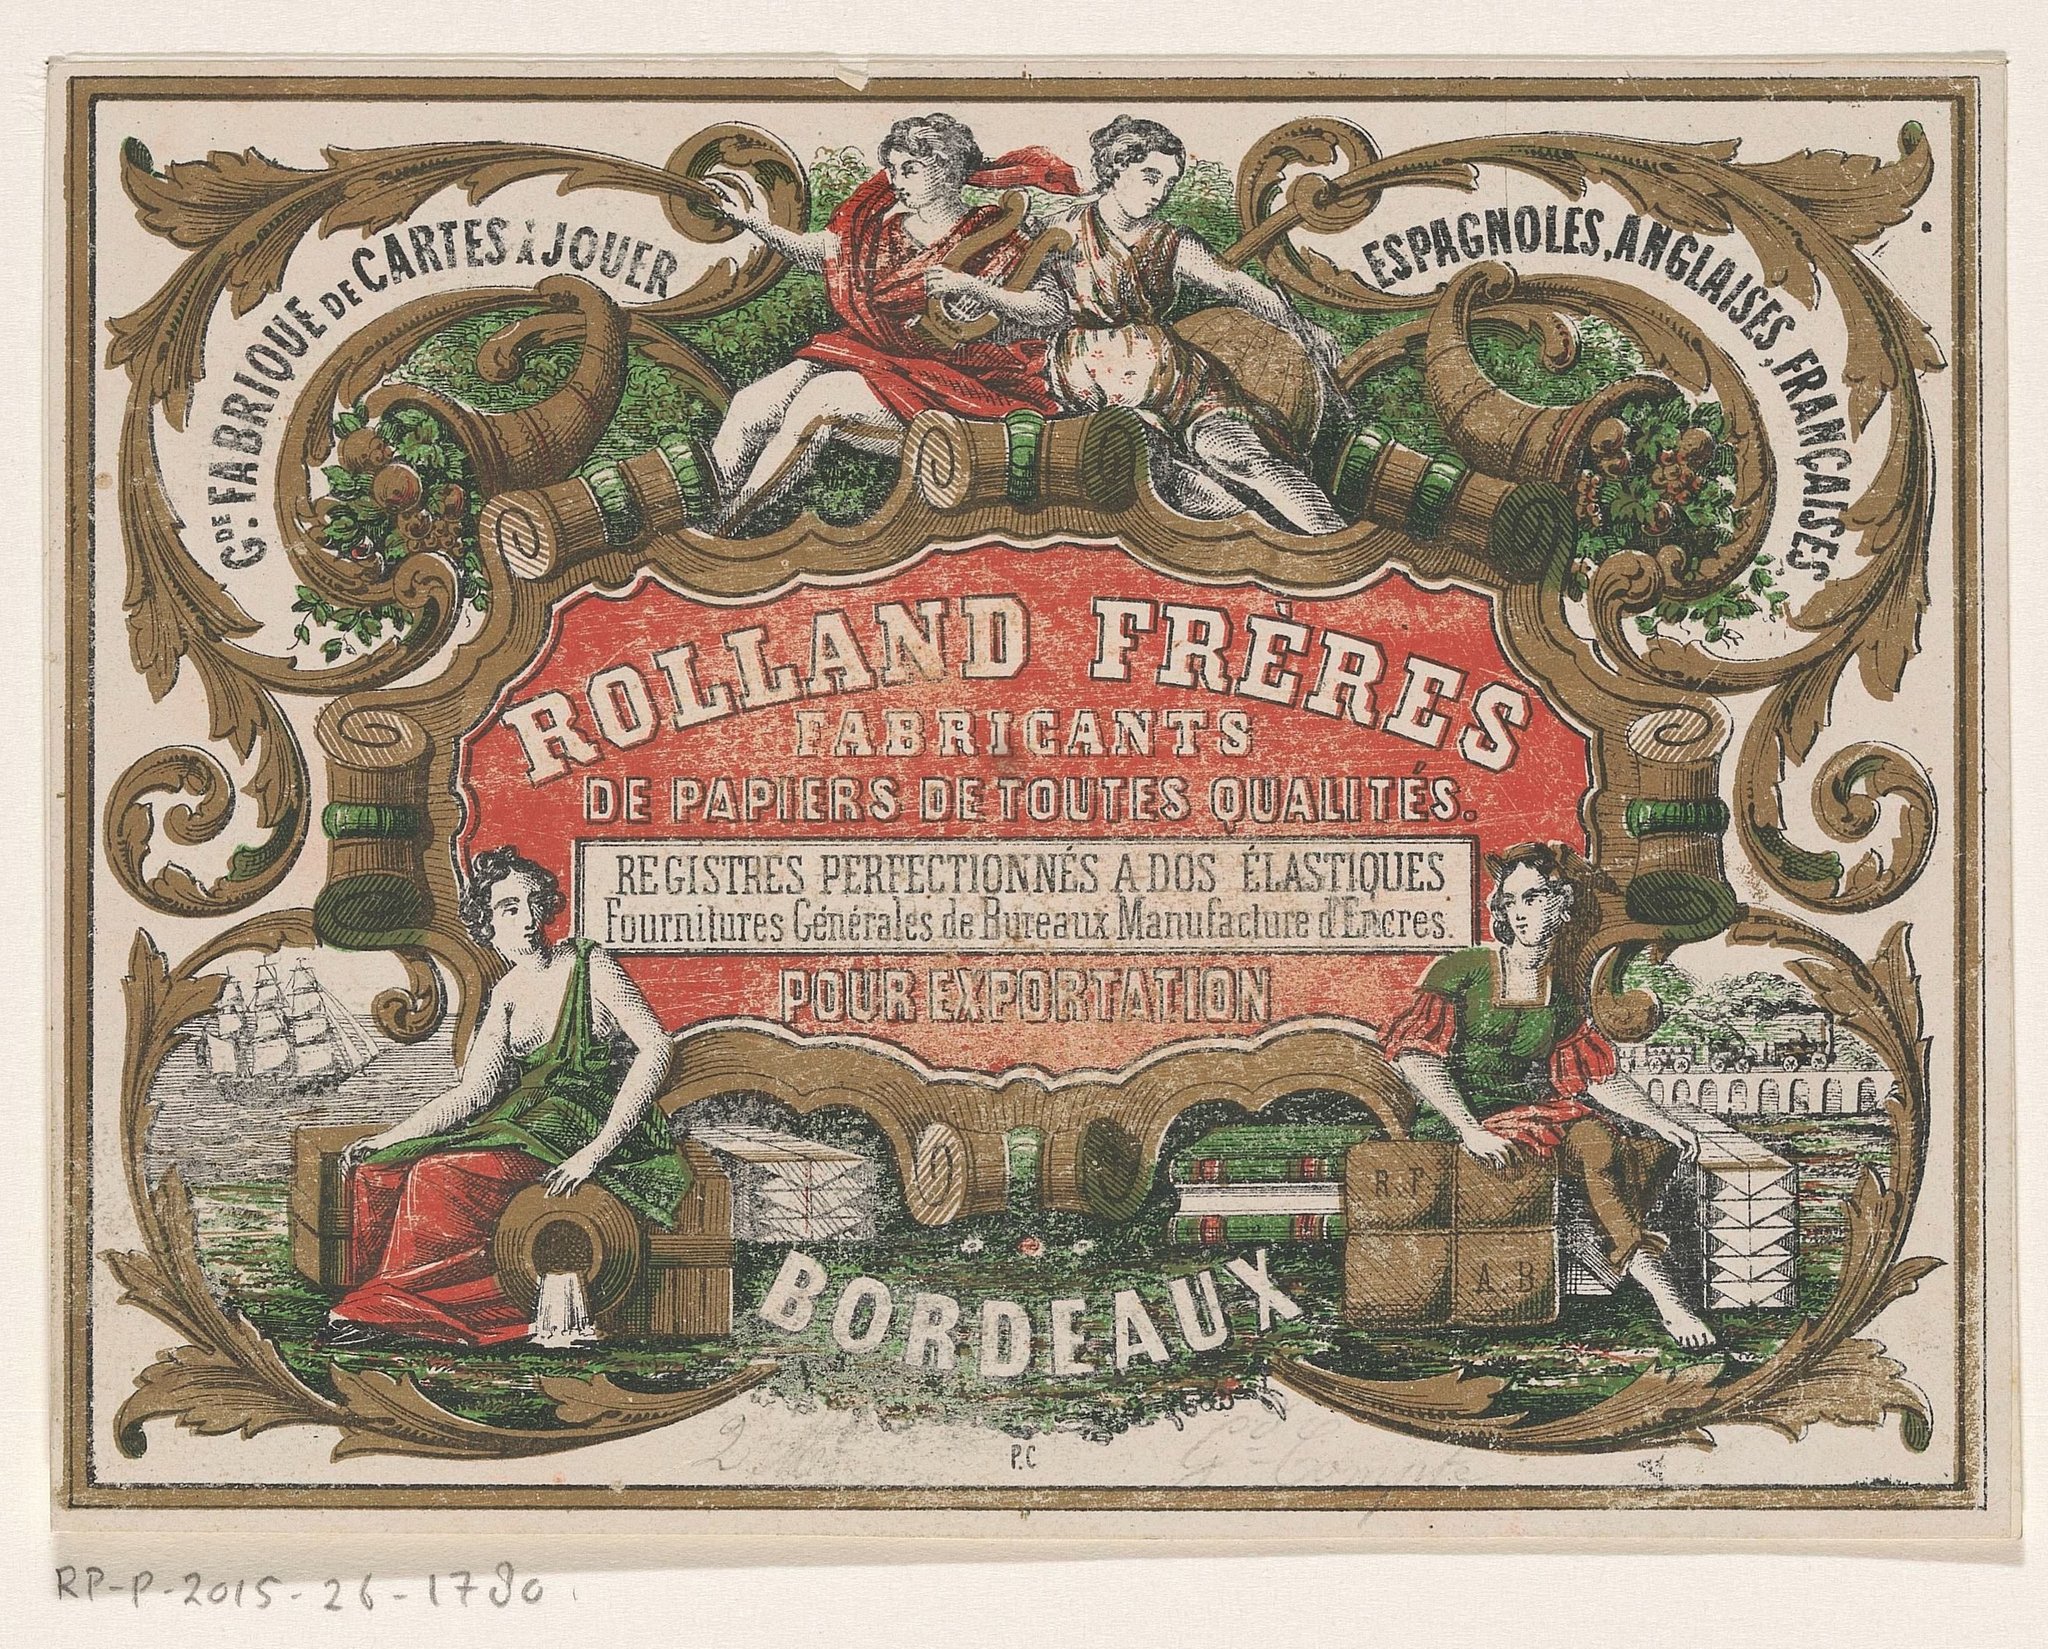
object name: visiting card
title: Visitekaartje van Rolland Frères, papierfabrikant te Bordeaux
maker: monogrammist pc (lithograaf)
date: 1840-1875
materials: porcelainized cardboard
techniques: lithograph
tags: 'cornucopia', horn of plenty, ships (in general), paper (writing material), steam locomotive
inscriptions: collector's mark: Lugt 2228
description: Boven een vrouw met een wereldbol en een man met een lier, mogelijk stellen zij Apollo en Gaia voor. Linksonder een vrouw met een kruik op een kade, een schip in de achtergrond. Rechtsonder een man omringd door stapels papier en registers, een stoomtrein in de achtergrond.